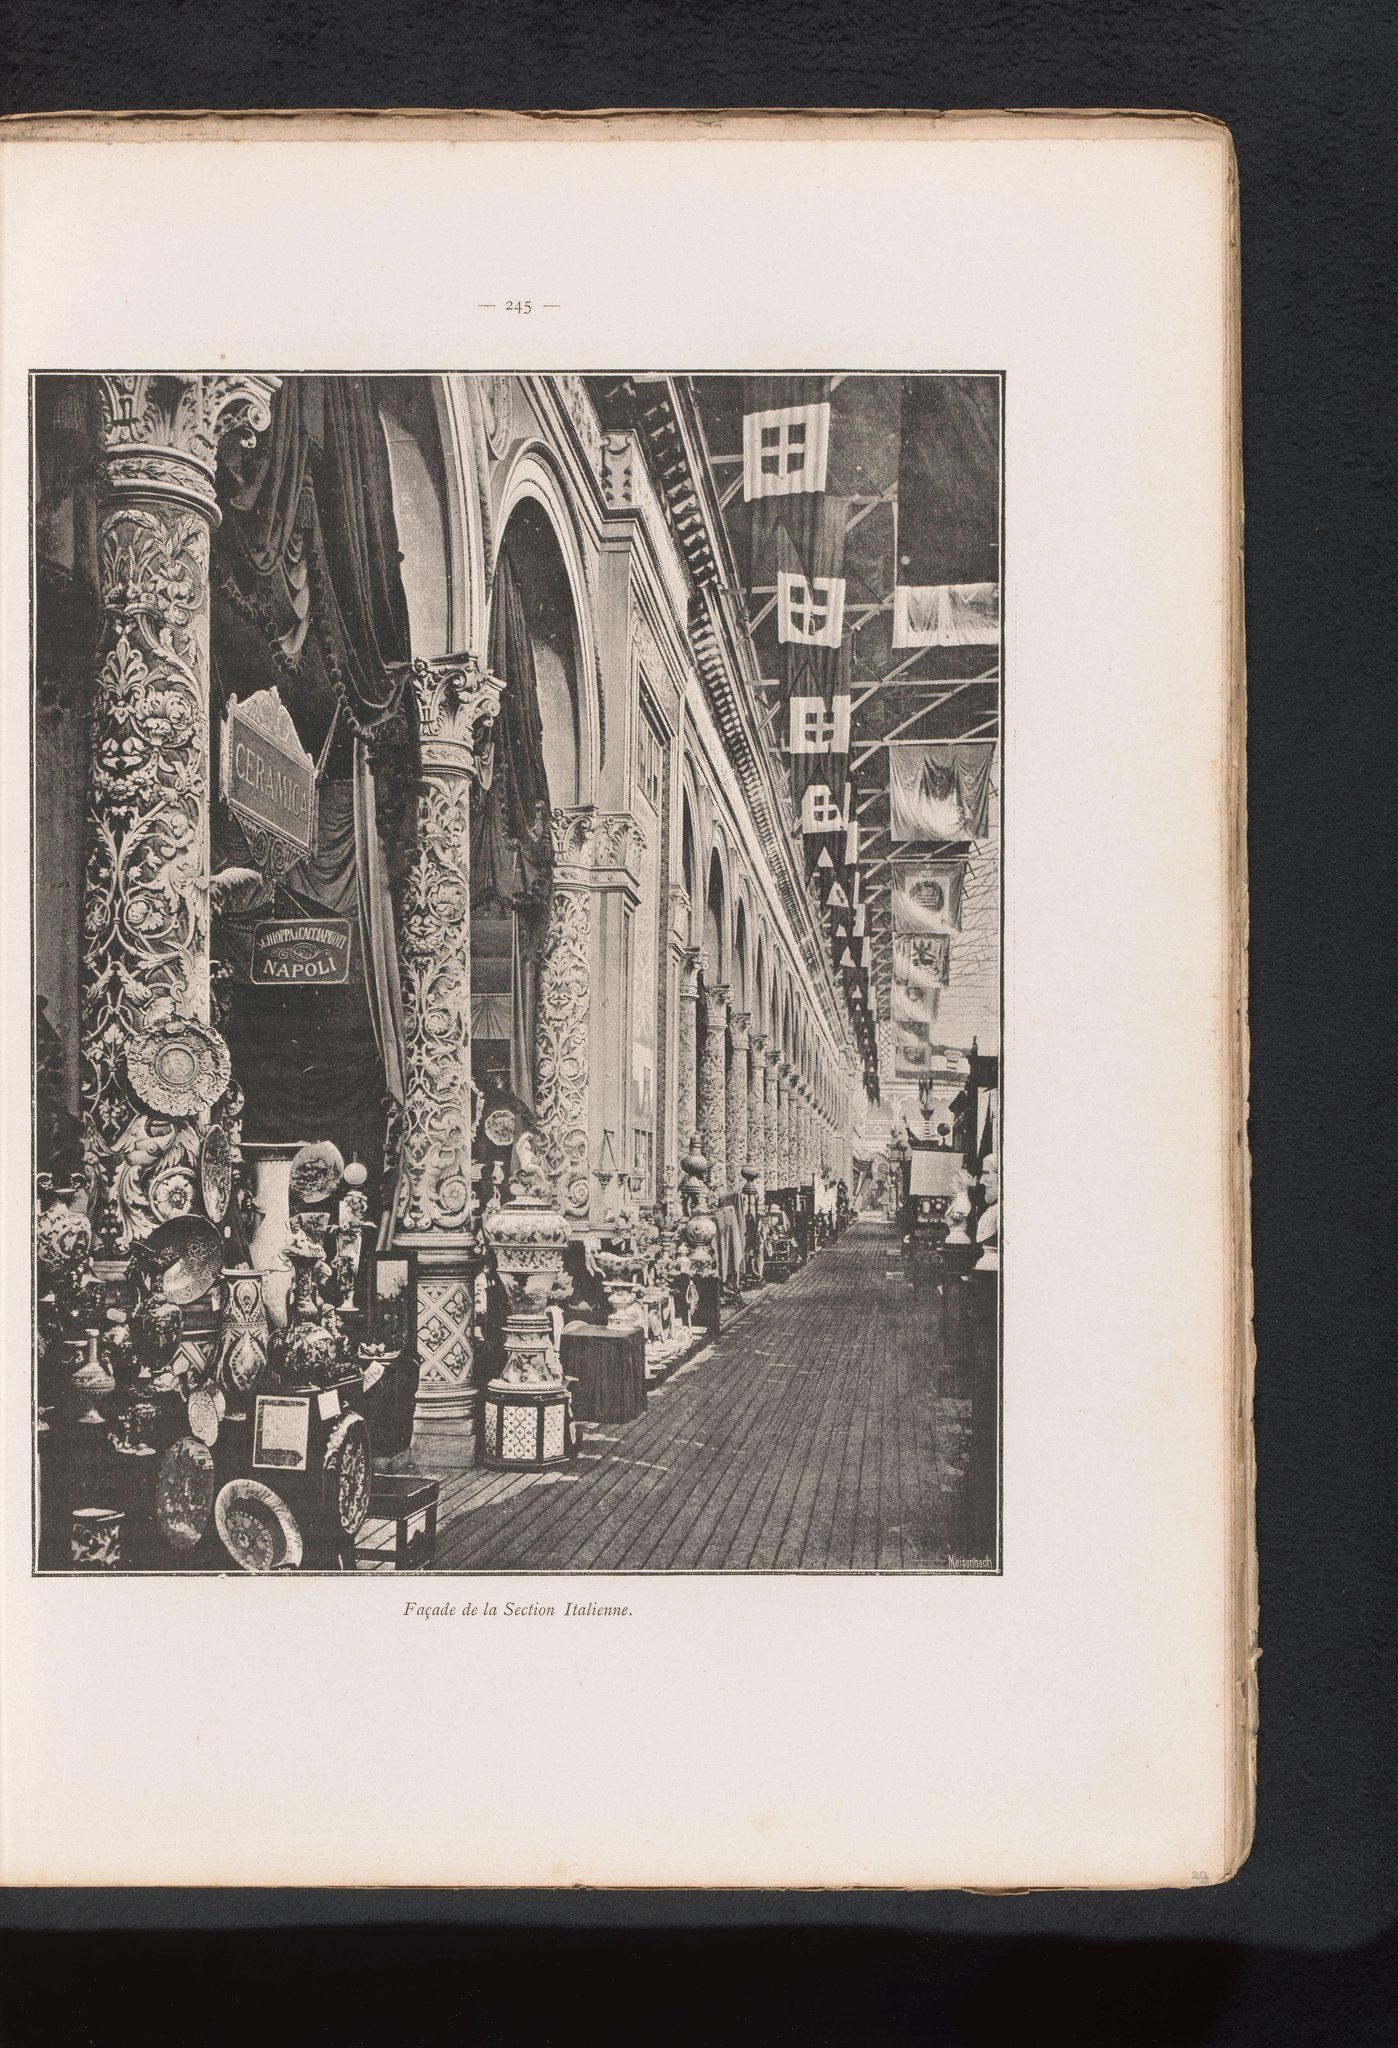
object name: photomechanical print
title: Gezicht op het Italiaanse deel van de Wereldtentoonstelling van 1885 in Antwerpen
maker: Anonymous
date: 1880-1885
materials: paper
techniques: autotype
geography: antwerp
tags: world fair, world exhibition, antwerp